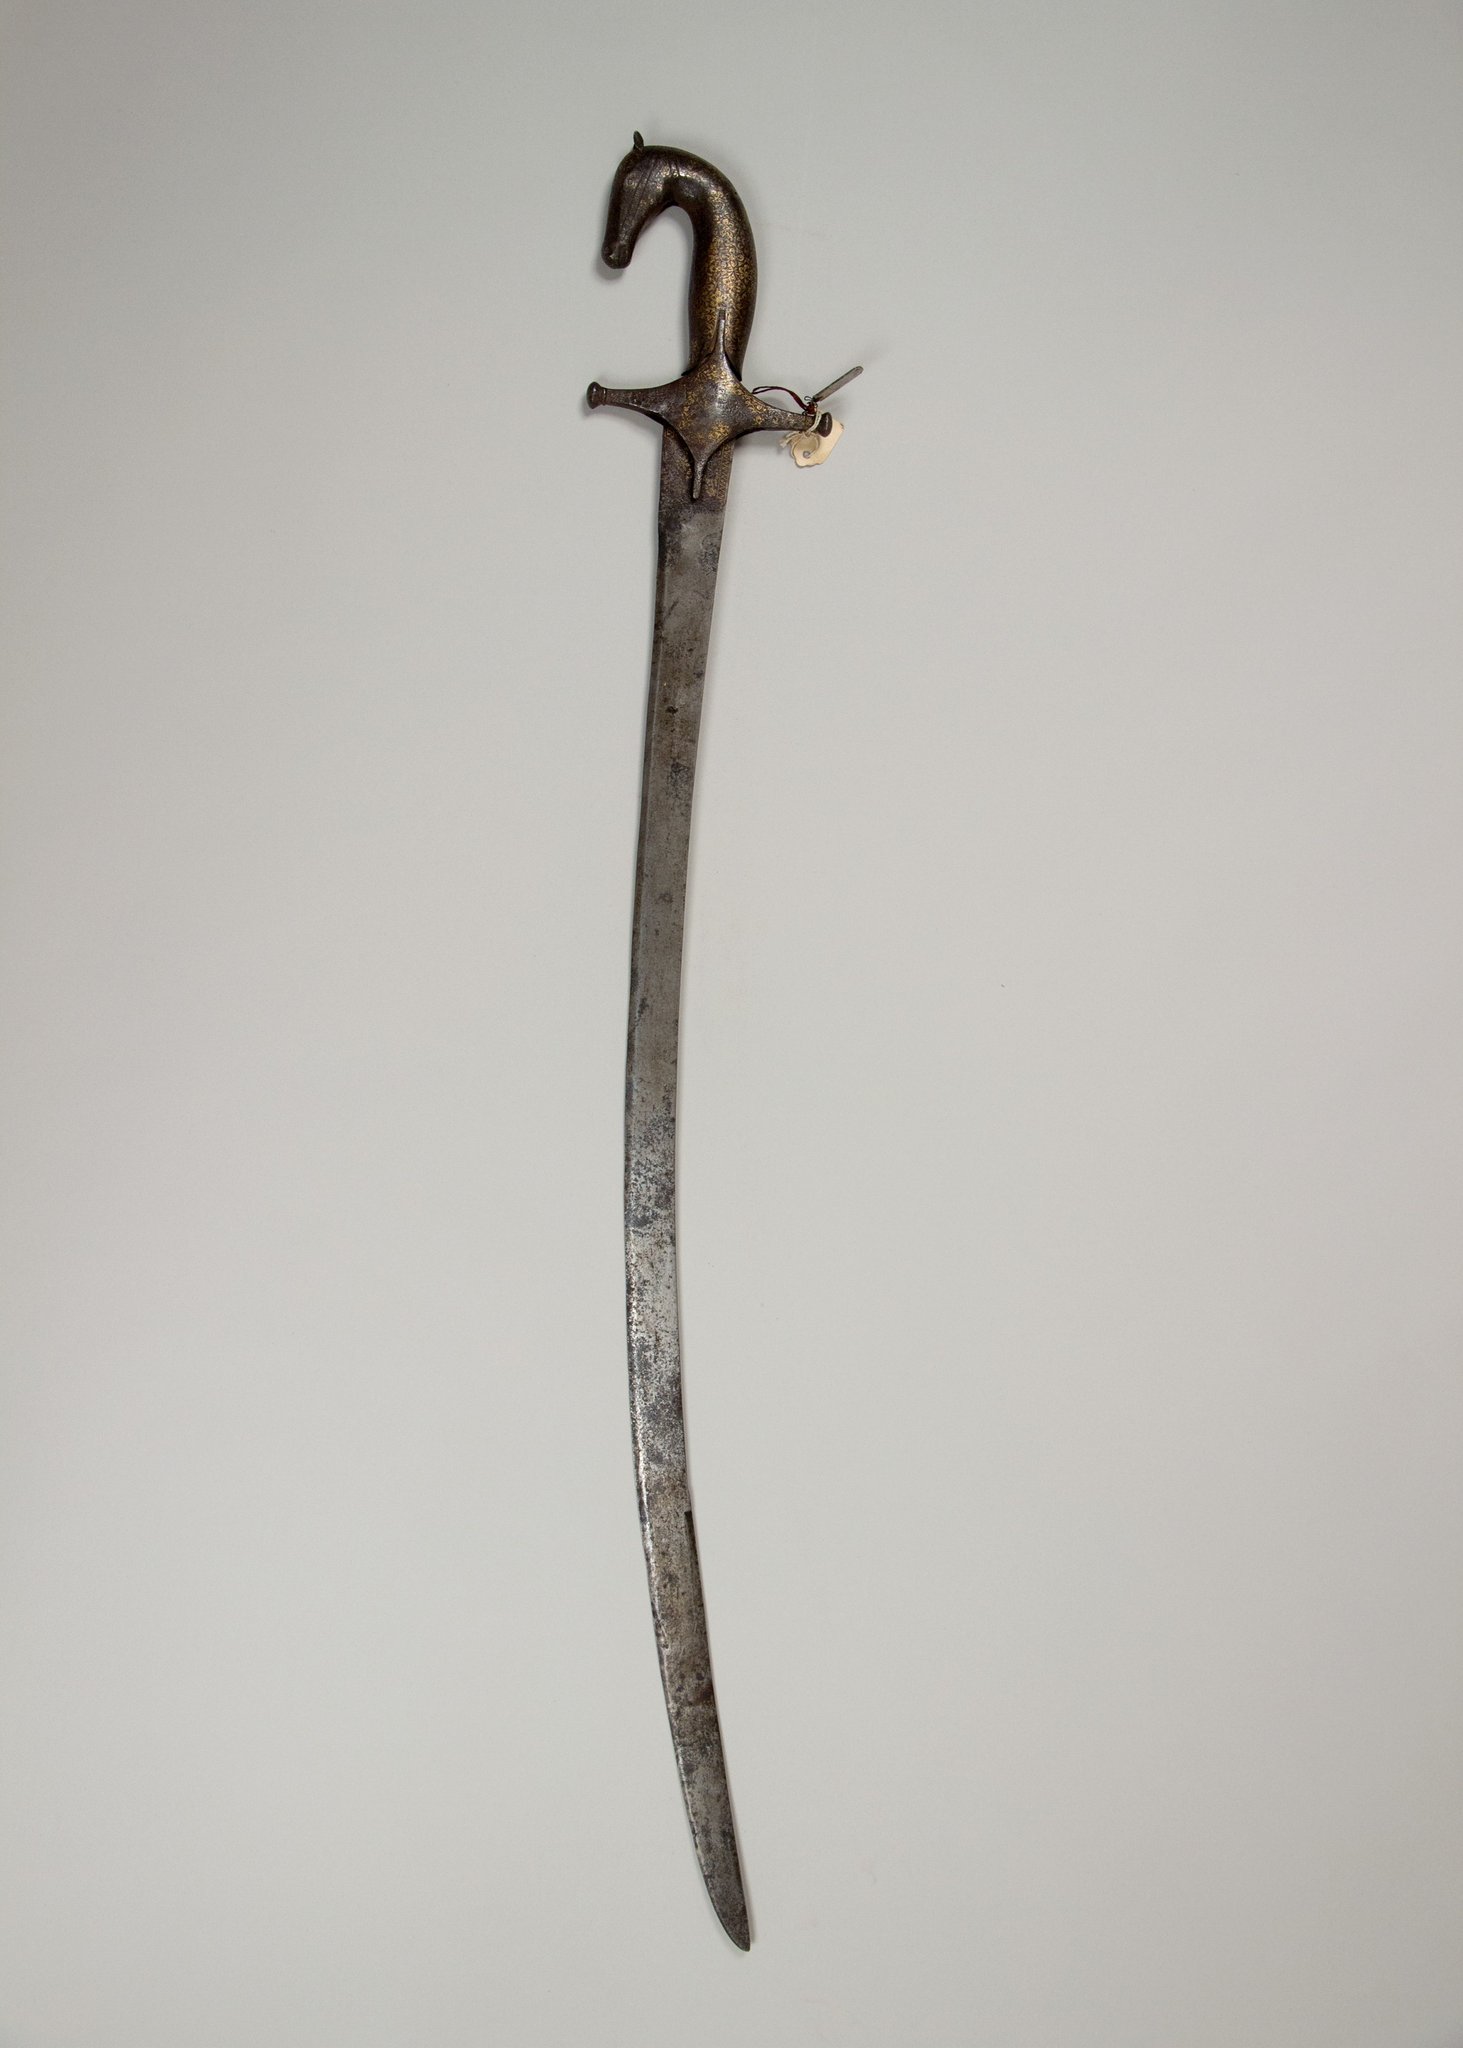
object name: sword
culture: indian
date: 1801-1900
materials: gold, iron, steel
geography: india